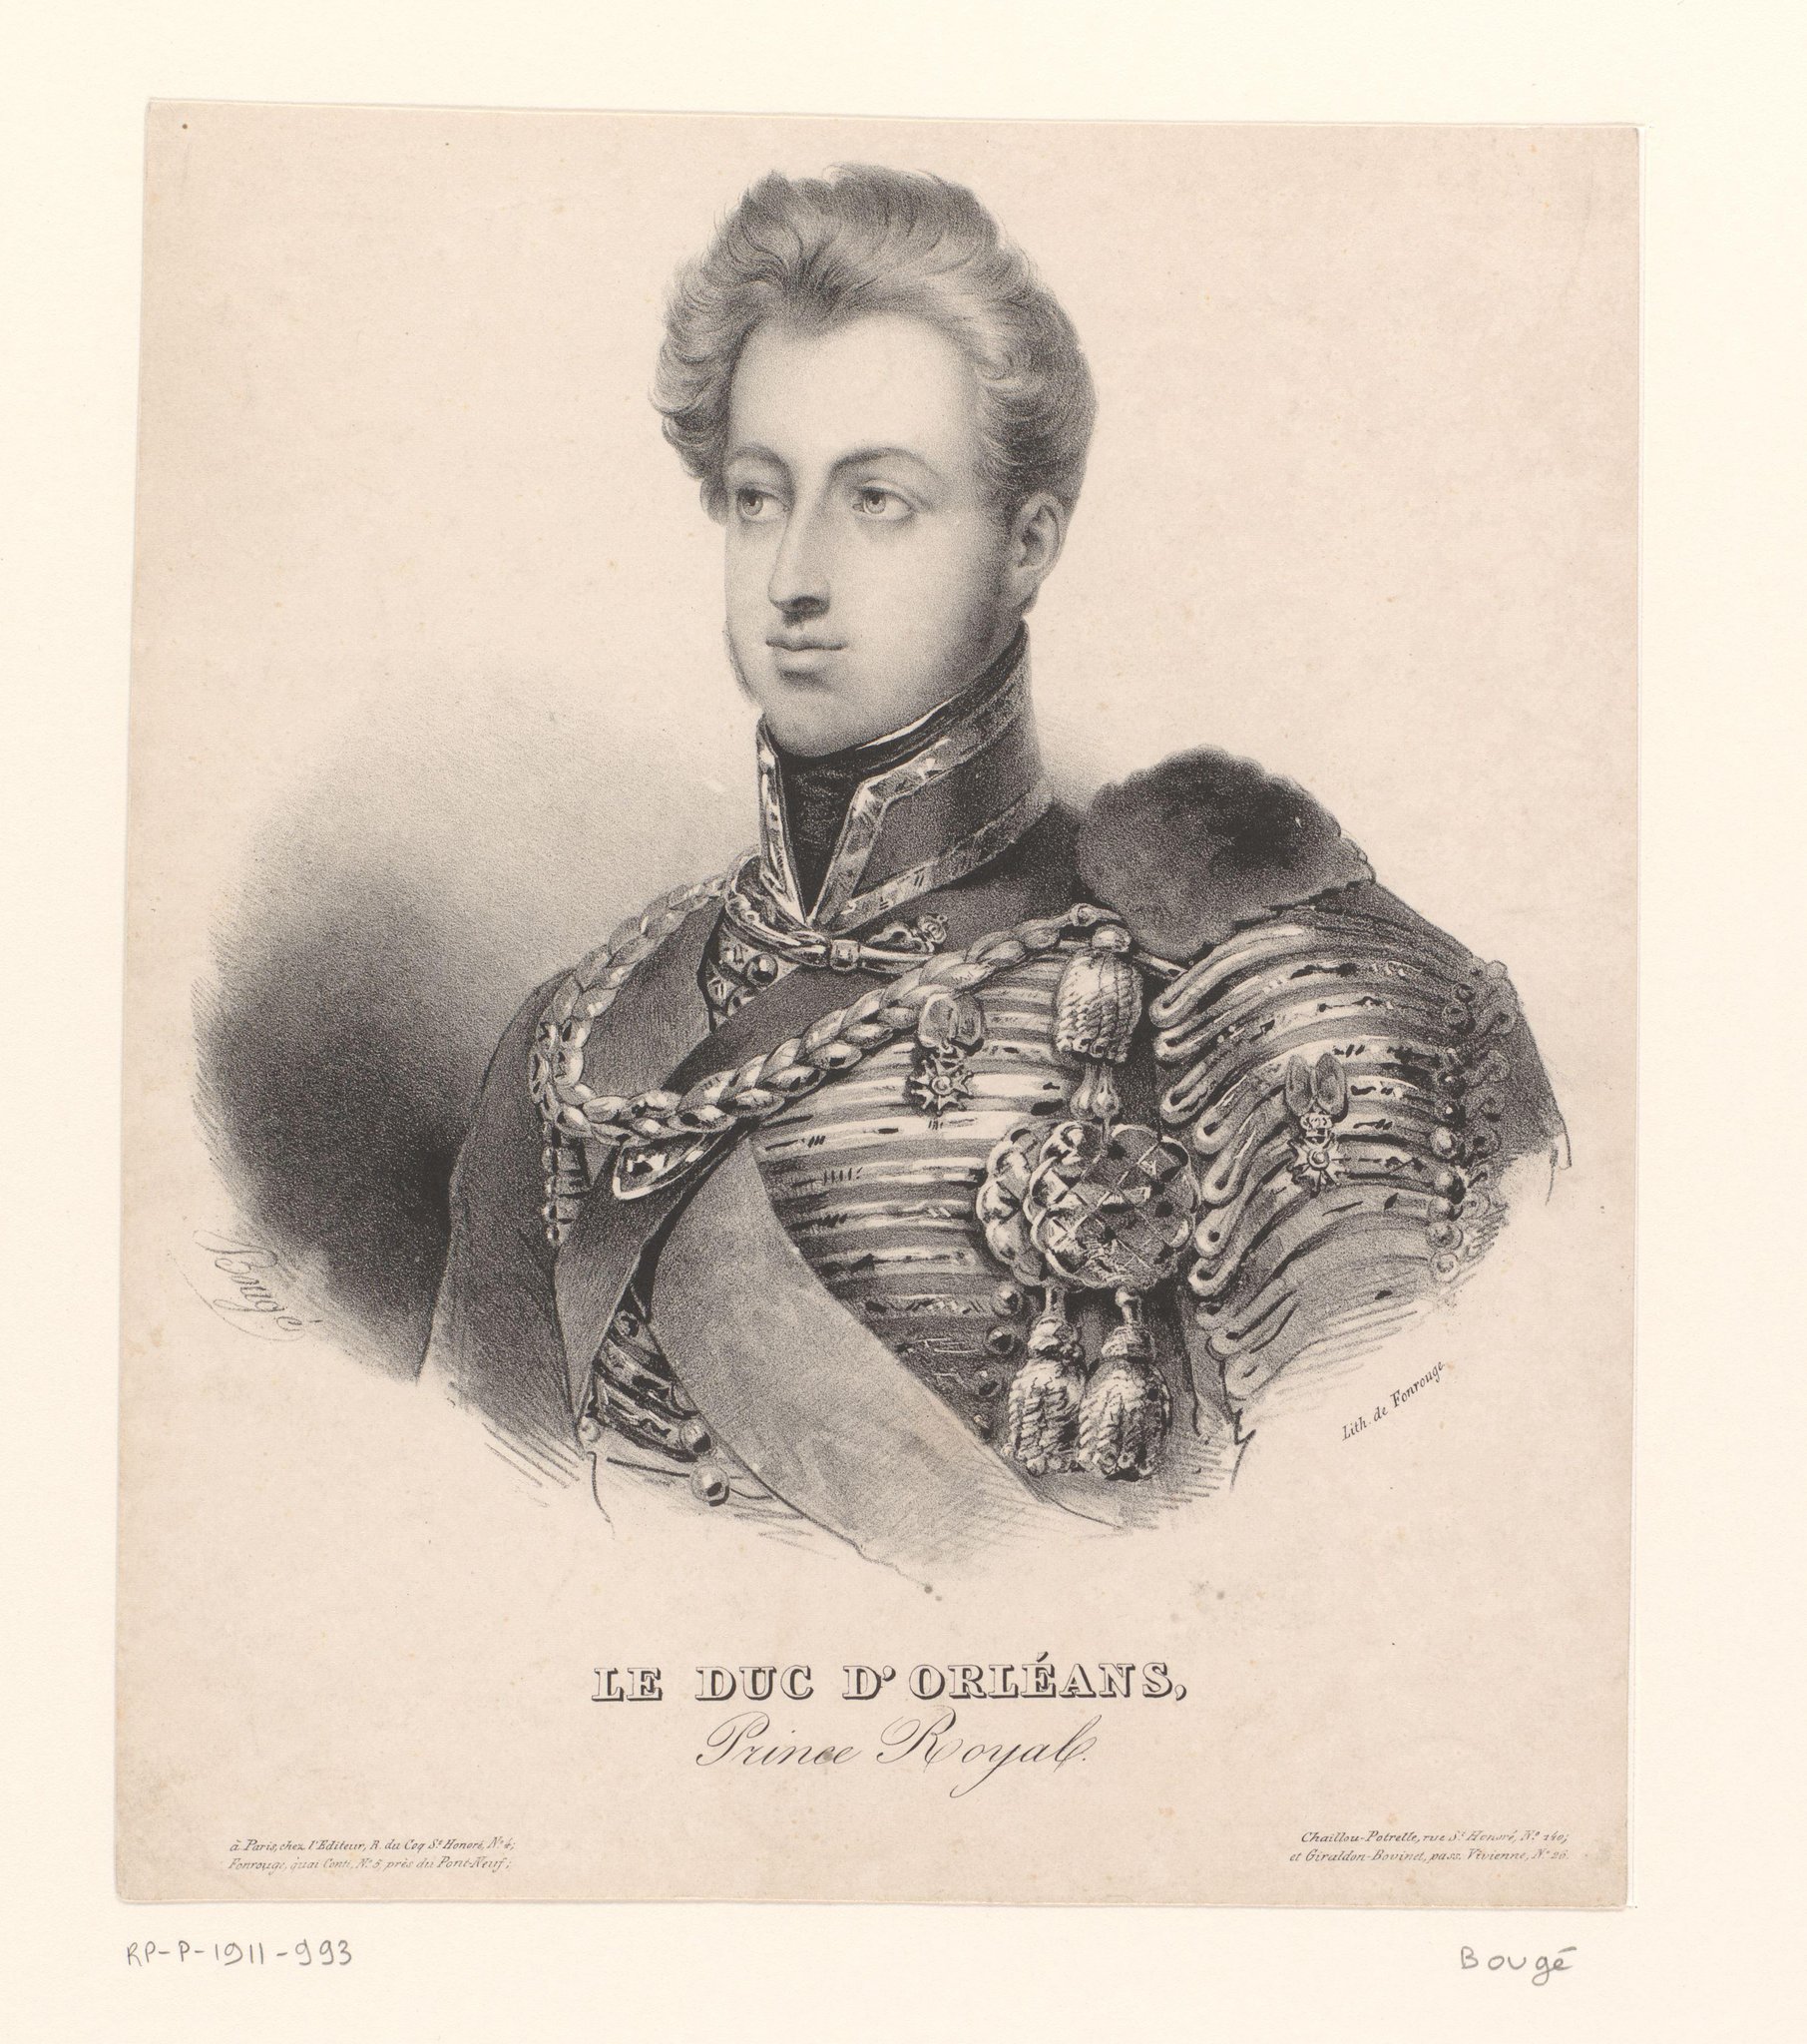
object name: print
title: Le duc d'Orléans, Prince Royal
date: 1831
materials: paper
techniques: lithograph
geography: paris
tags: historical persons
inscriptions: collector's mark: Lugt 2228a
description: Prent gepubliceerd in: 'Galerie Universelle de Blaisot', een boek met 38 portretten van eminente mannen en vrouwen van de zeventiende tot en met de negentiende eeuw.